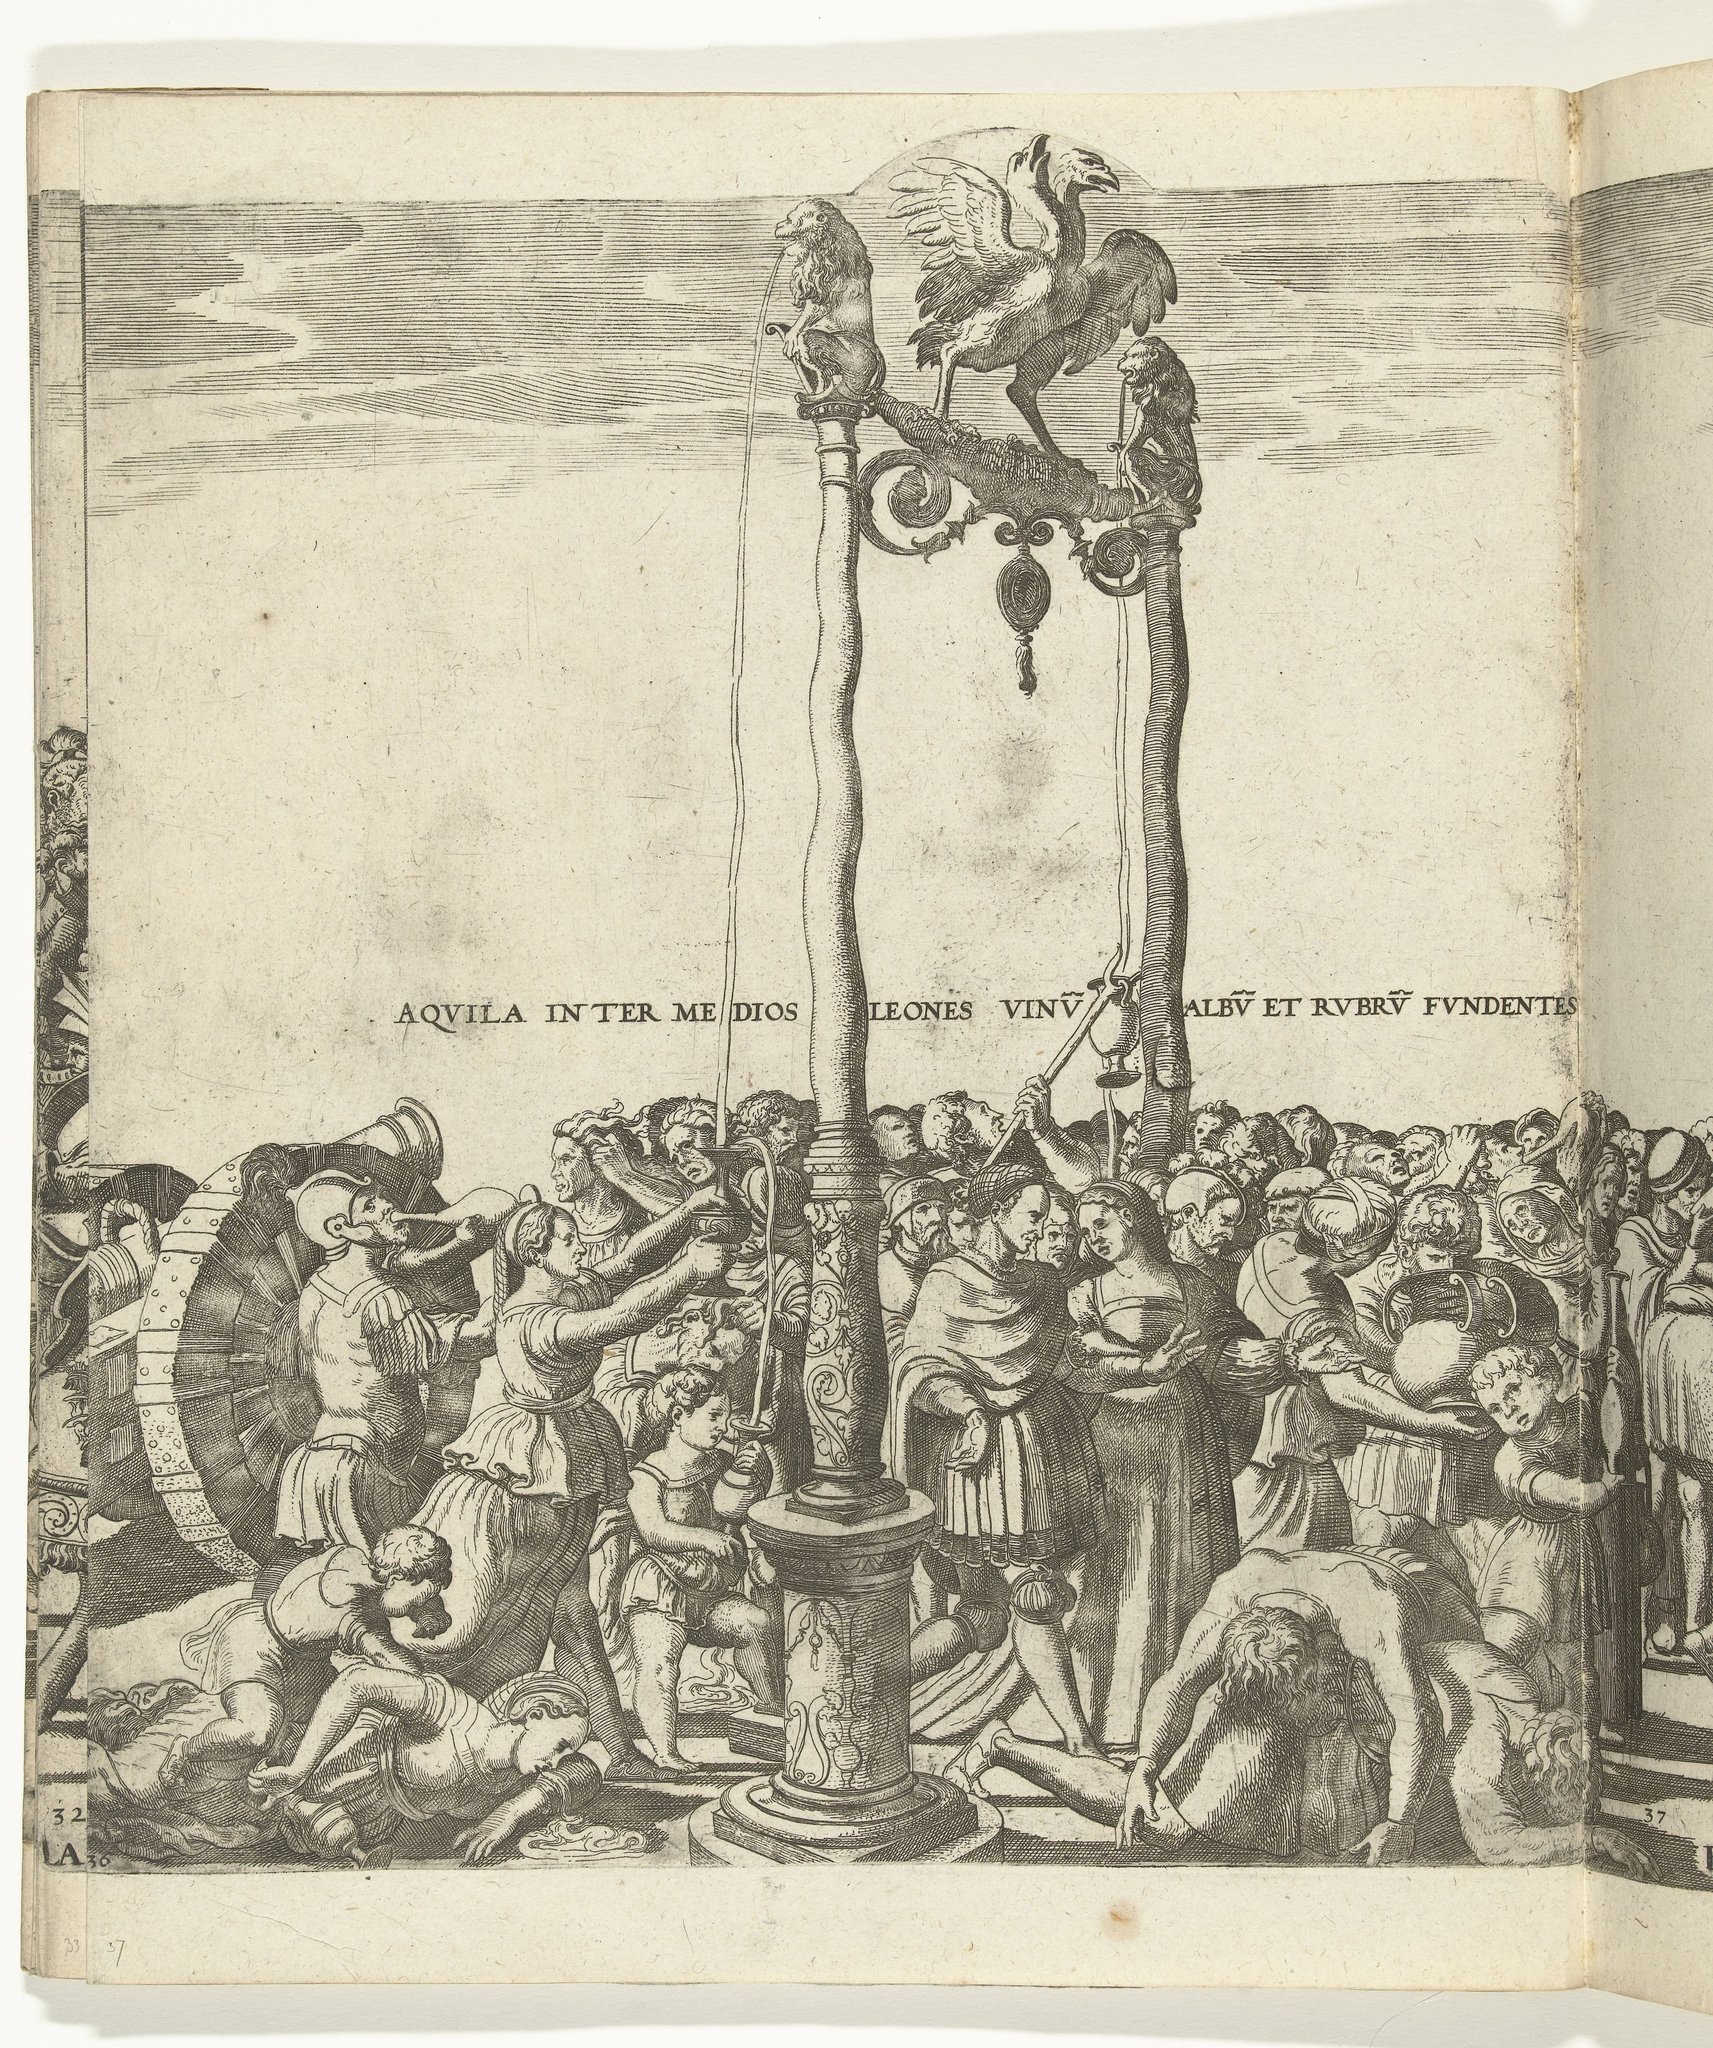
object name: print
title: Optocht van Karel V met de paus te Bologna na zijn kroning tot keizer, 1530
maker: nicolaas hogenberg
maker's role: draughtsman, painter, print maker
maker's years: 1500-1539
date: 1530-1536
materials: paper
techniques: engraving, etching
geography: mechelen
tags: ghent, charles v (holy roman emperor and king of spain), drunkard, festivities (+ parade, pageant, cavalcade ~ festive activities)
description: In plaats van de geneologische afstamming van Karel V in het huis van Oostenrijk is in deze uitgave bovenin de platen een nieuw lucht gegraveerd. De platen zijn genummerd 1-38. Deze uitgave is later dan die van Hondius. De platen zijn aanelkaar geplakt en vormen zo één lang (opgevouwen) fries. Het opgevouwen fries ligt los in een map.